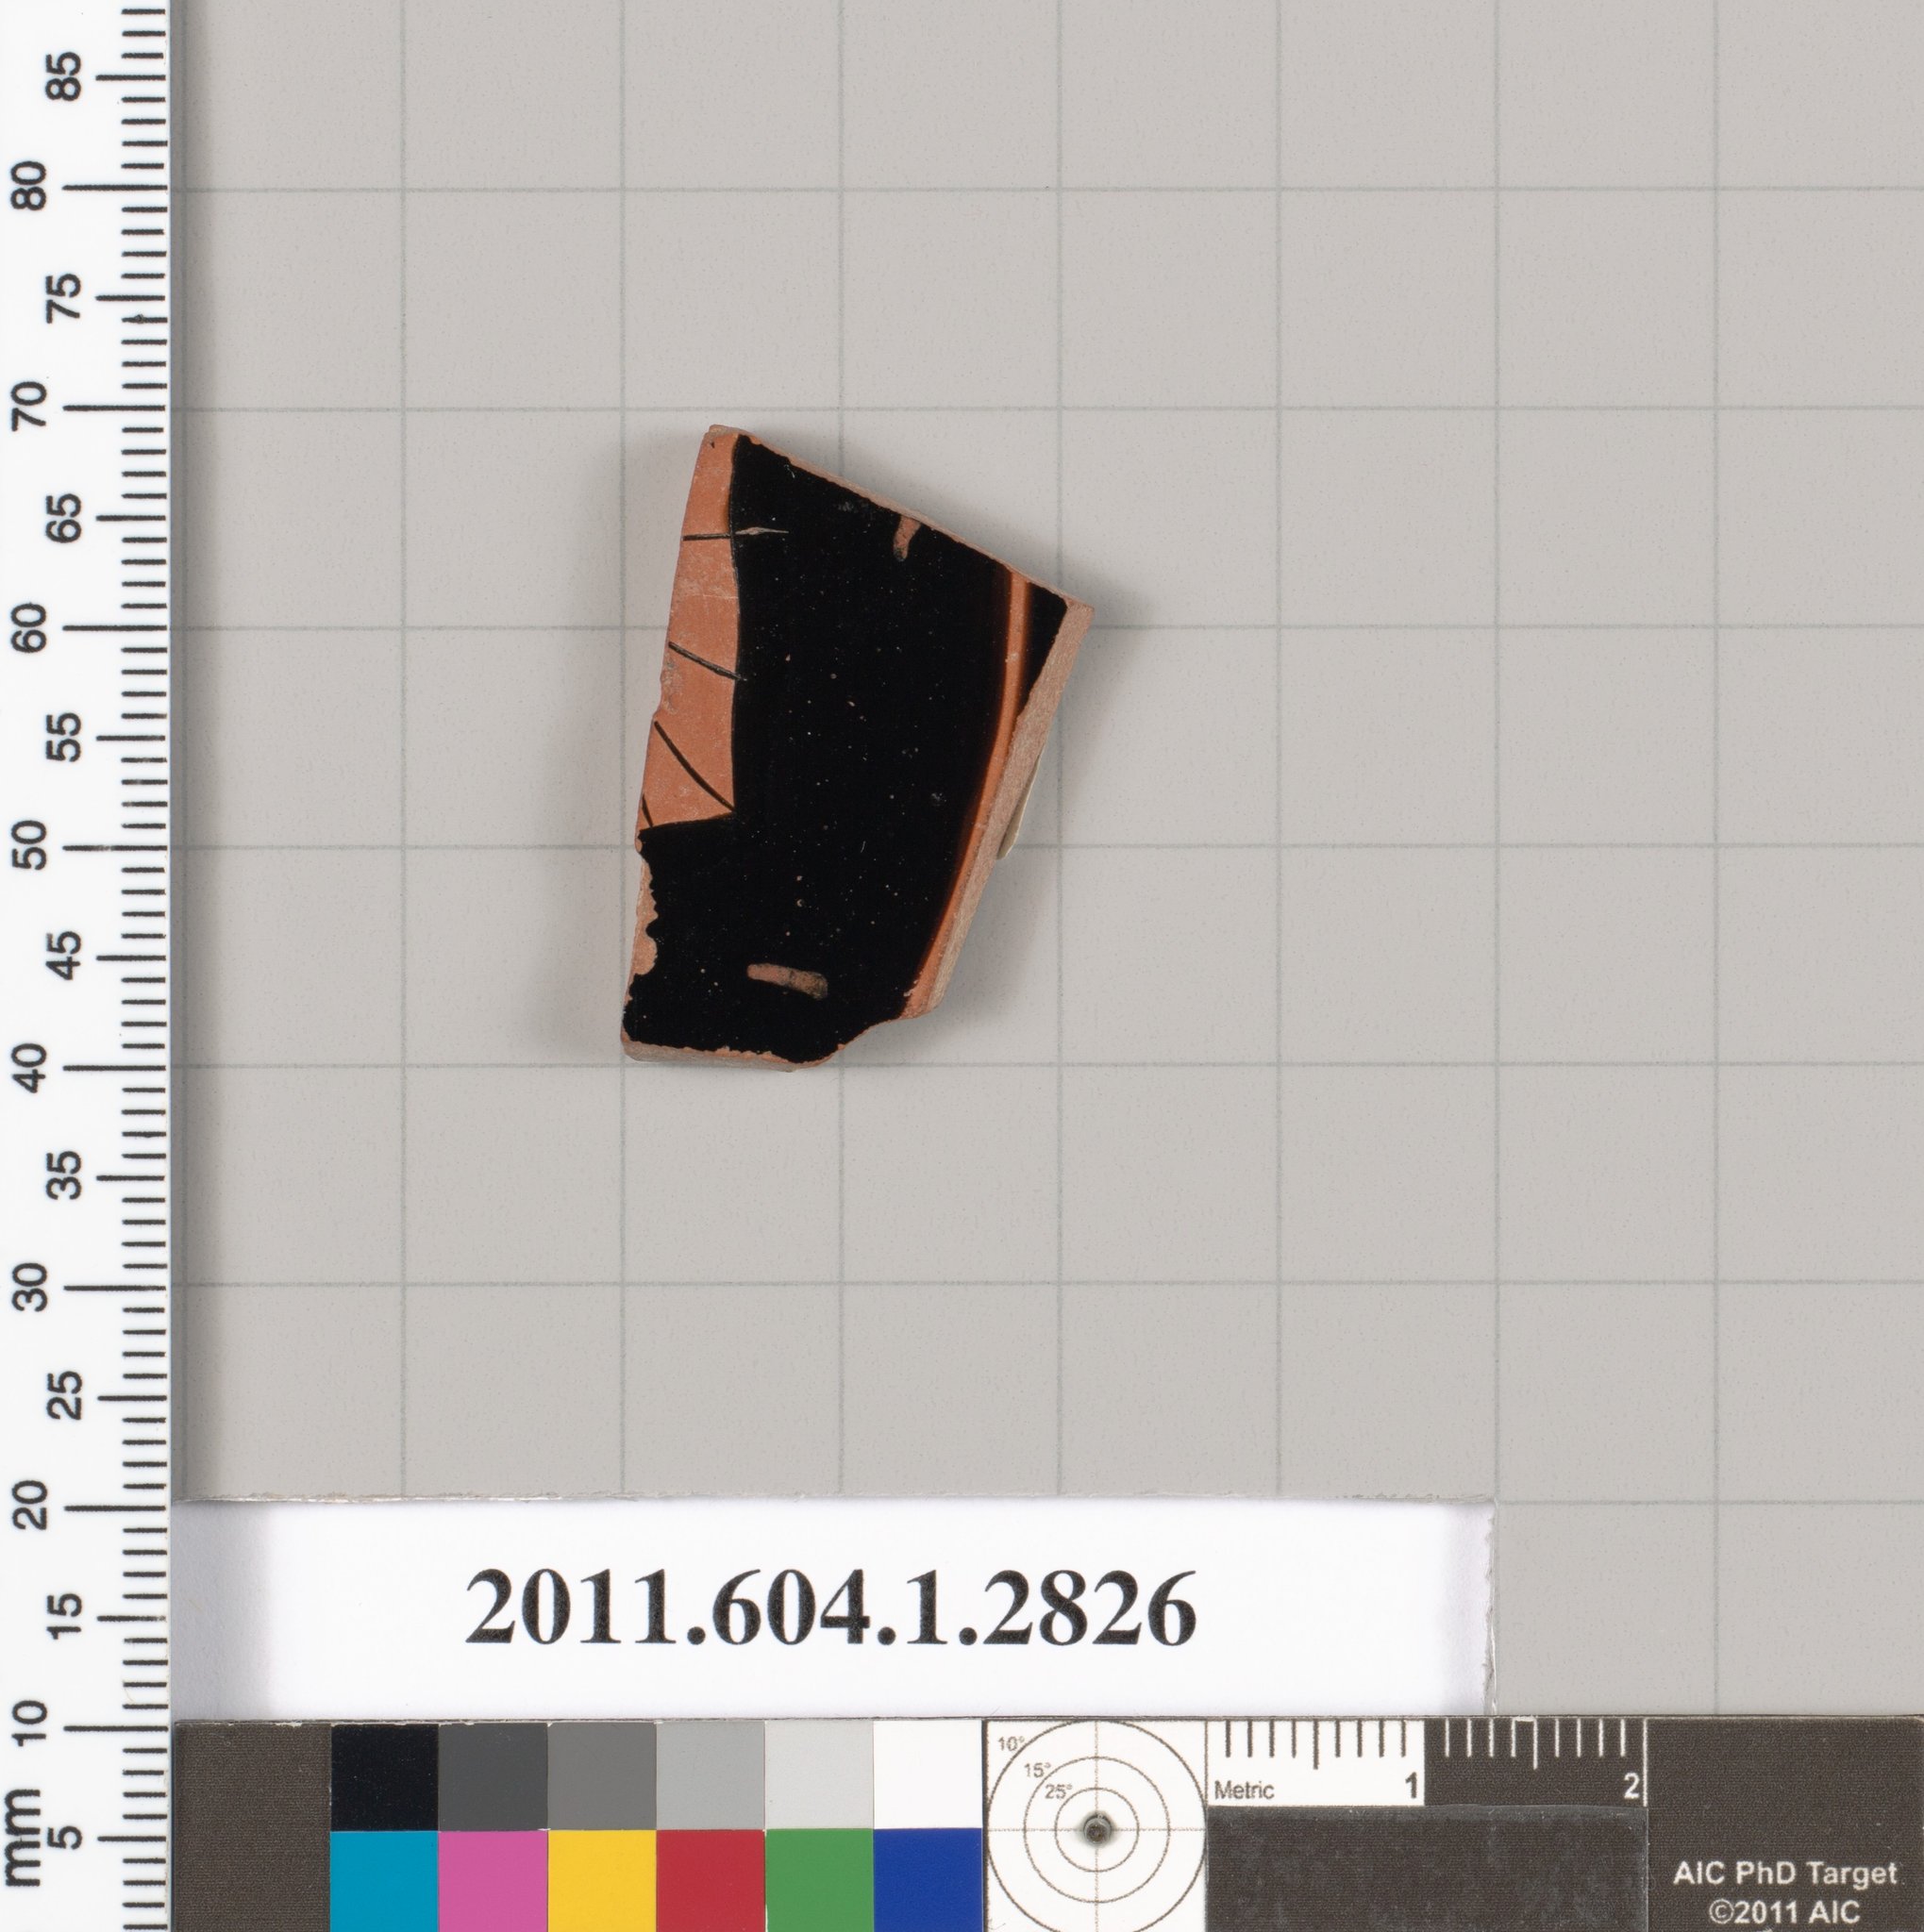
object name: kylix fragment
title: Terracotta fragment of a kylix (drinking cup)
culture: greek, attic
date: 520-500 BCE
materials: terracotta